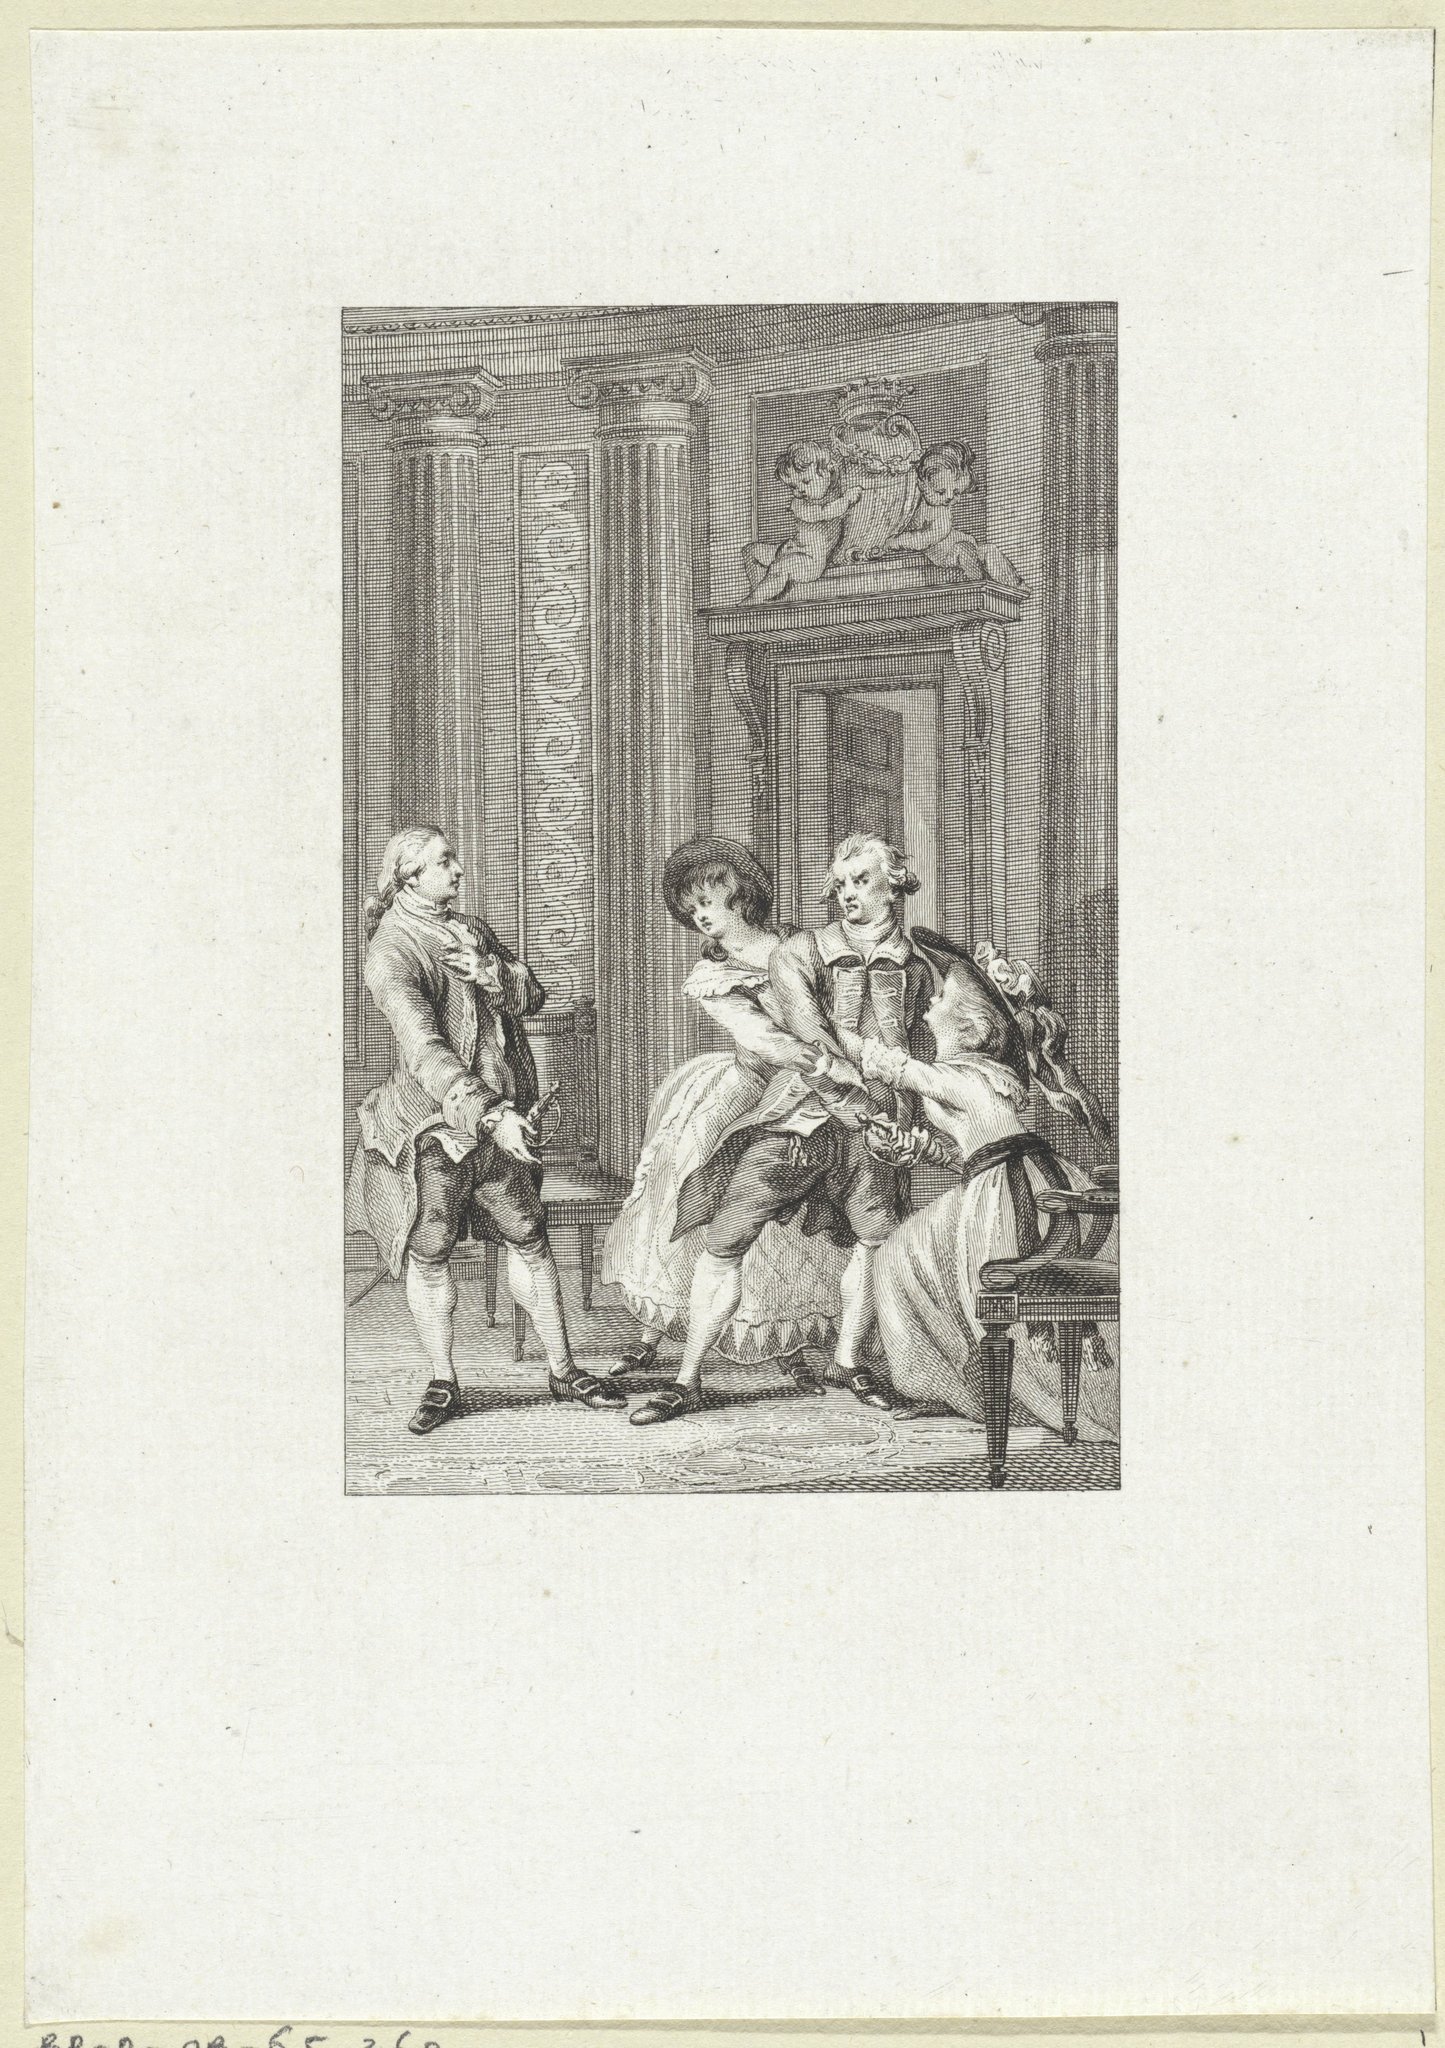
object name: print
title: Heer daagt een ander uit voor een gevecht met de degen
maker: reinier vinkeles (i)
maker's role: draughtsman, print maker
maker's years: 1741-1816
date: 1786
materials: paper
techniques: engraving, etching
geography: amsterdam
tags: hacking and thrusting weapons: sword, threatening behaviour, challenging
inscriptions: collector's mark: Lugt 240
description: Proefdruk van illustratie voor: King en Trueman, of de menschen-proef. Amsterdam: Erven Pieter Meĳer en Gerrit Warnars, 1786.